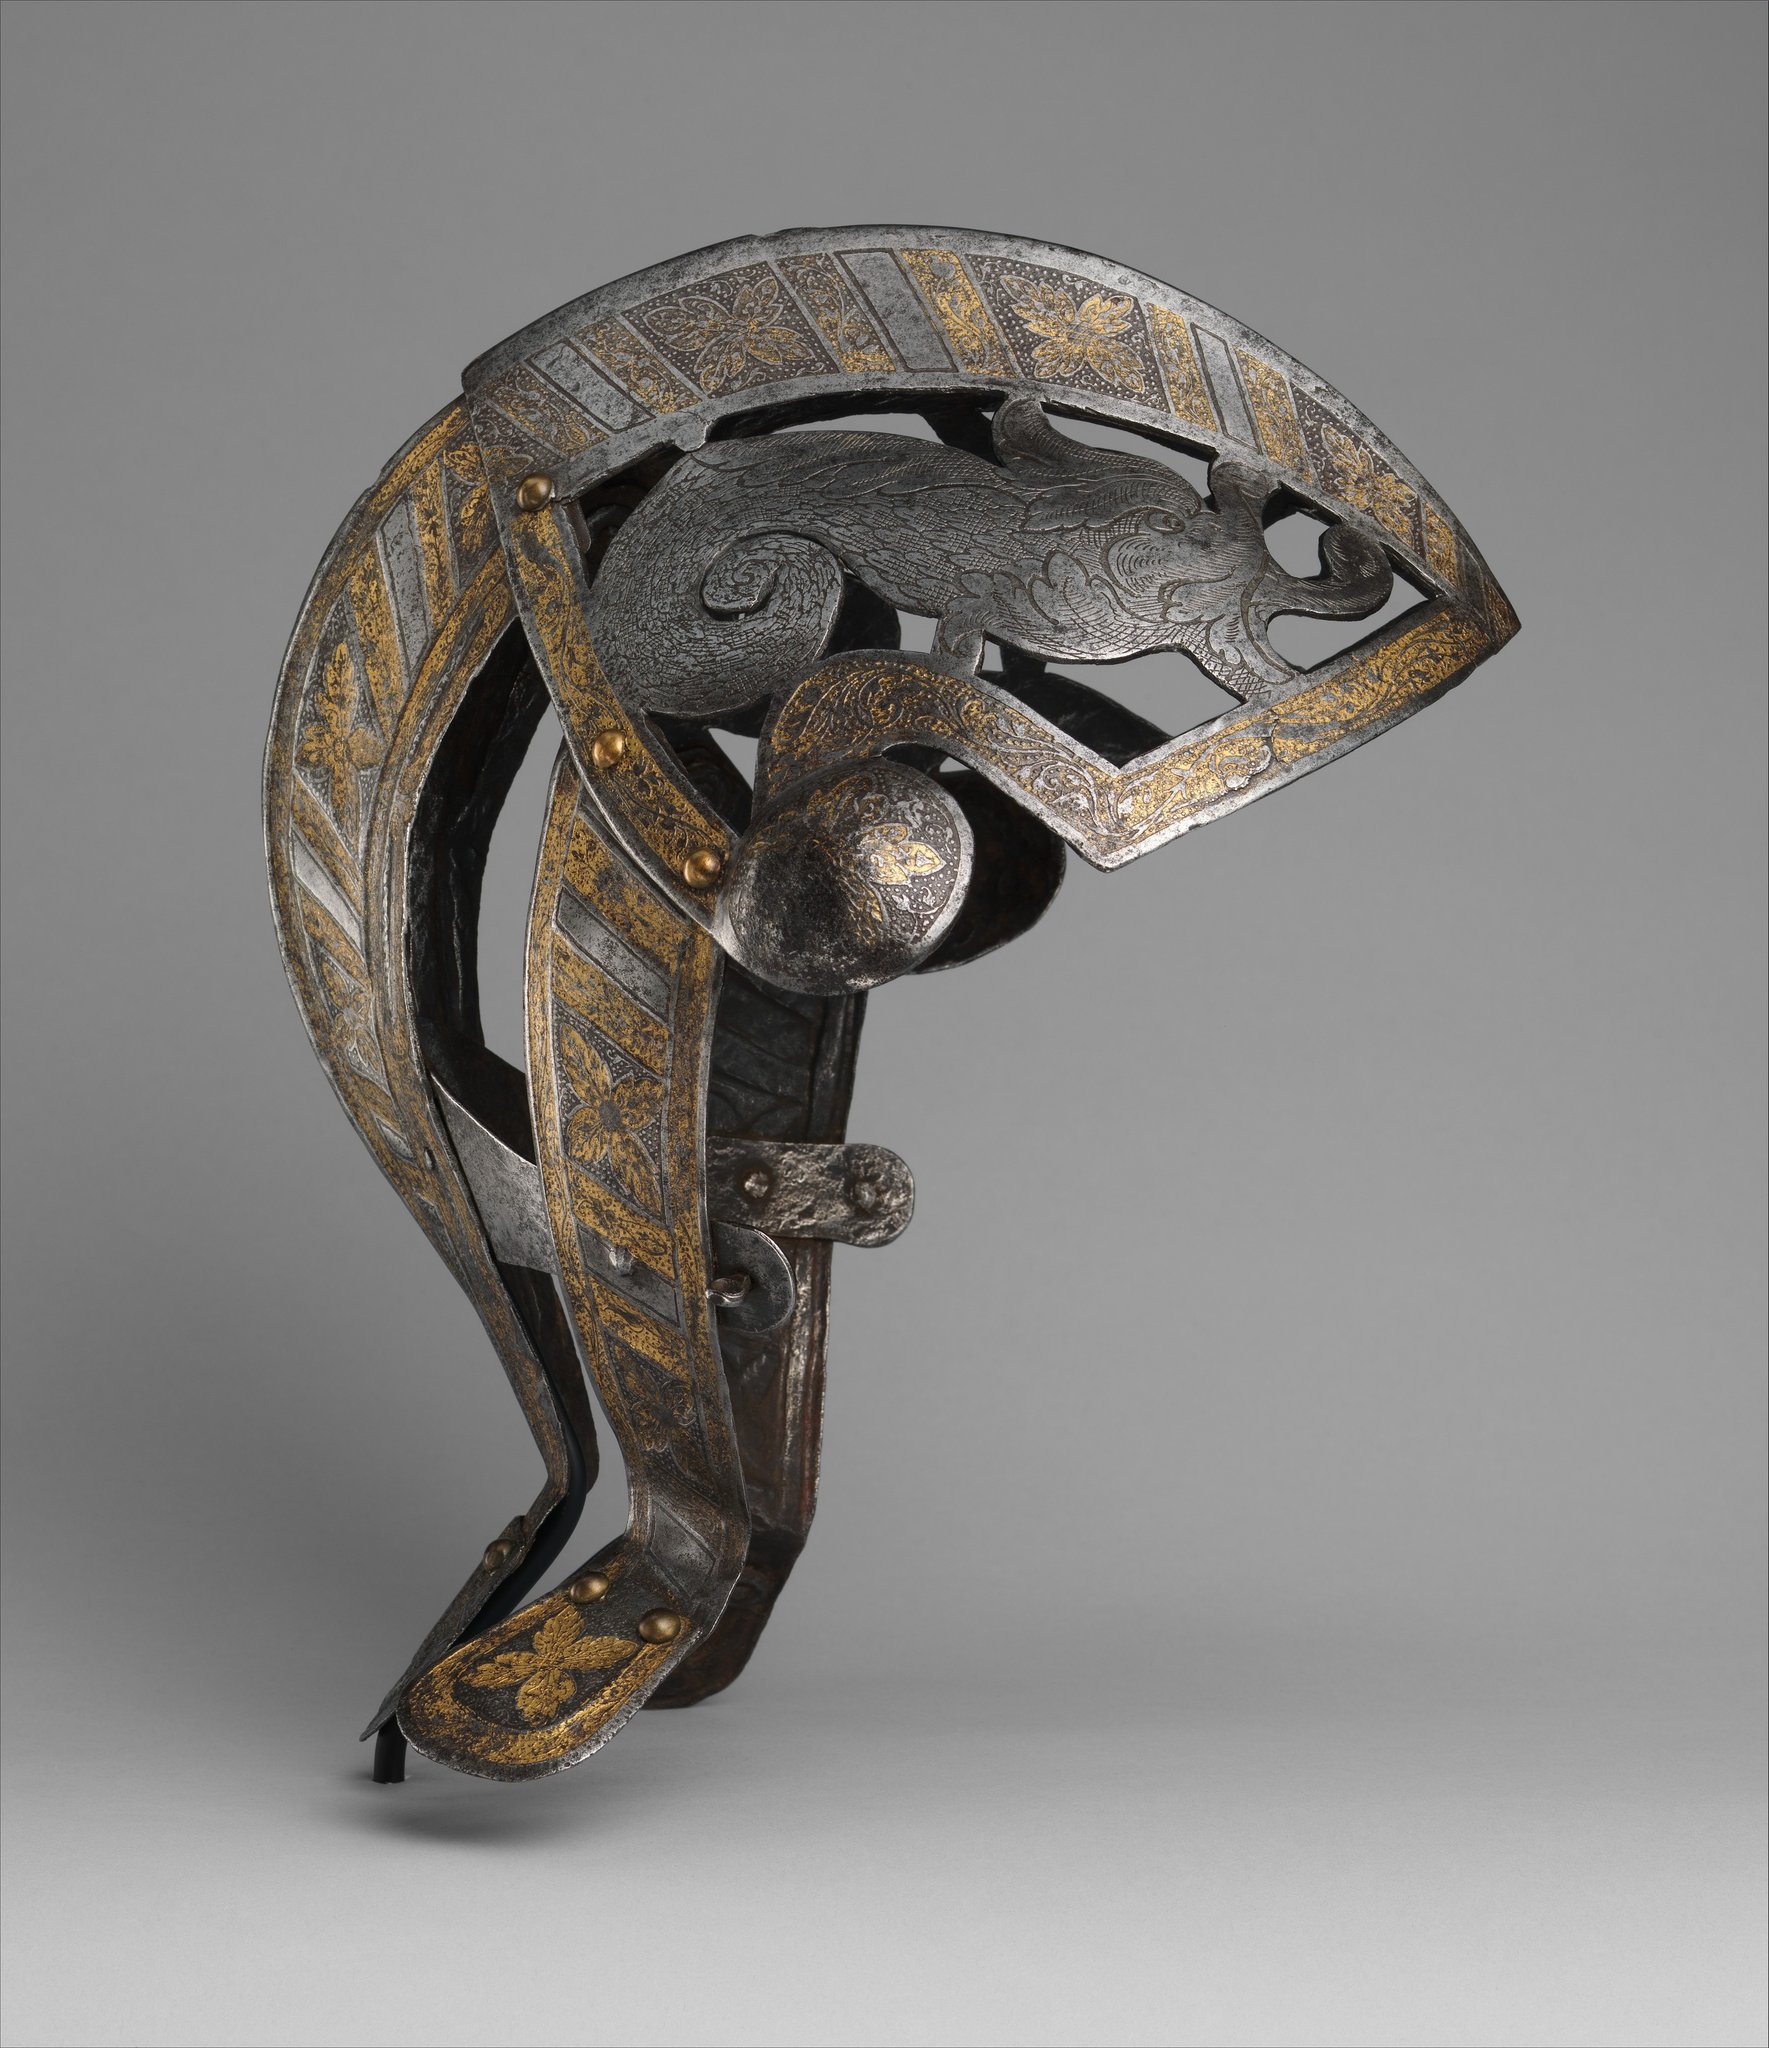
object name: reinforce for a helmet gupfe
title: Reinforce for a Helmet (Gupfe)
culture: german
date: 1550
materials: gold, steel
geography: germany